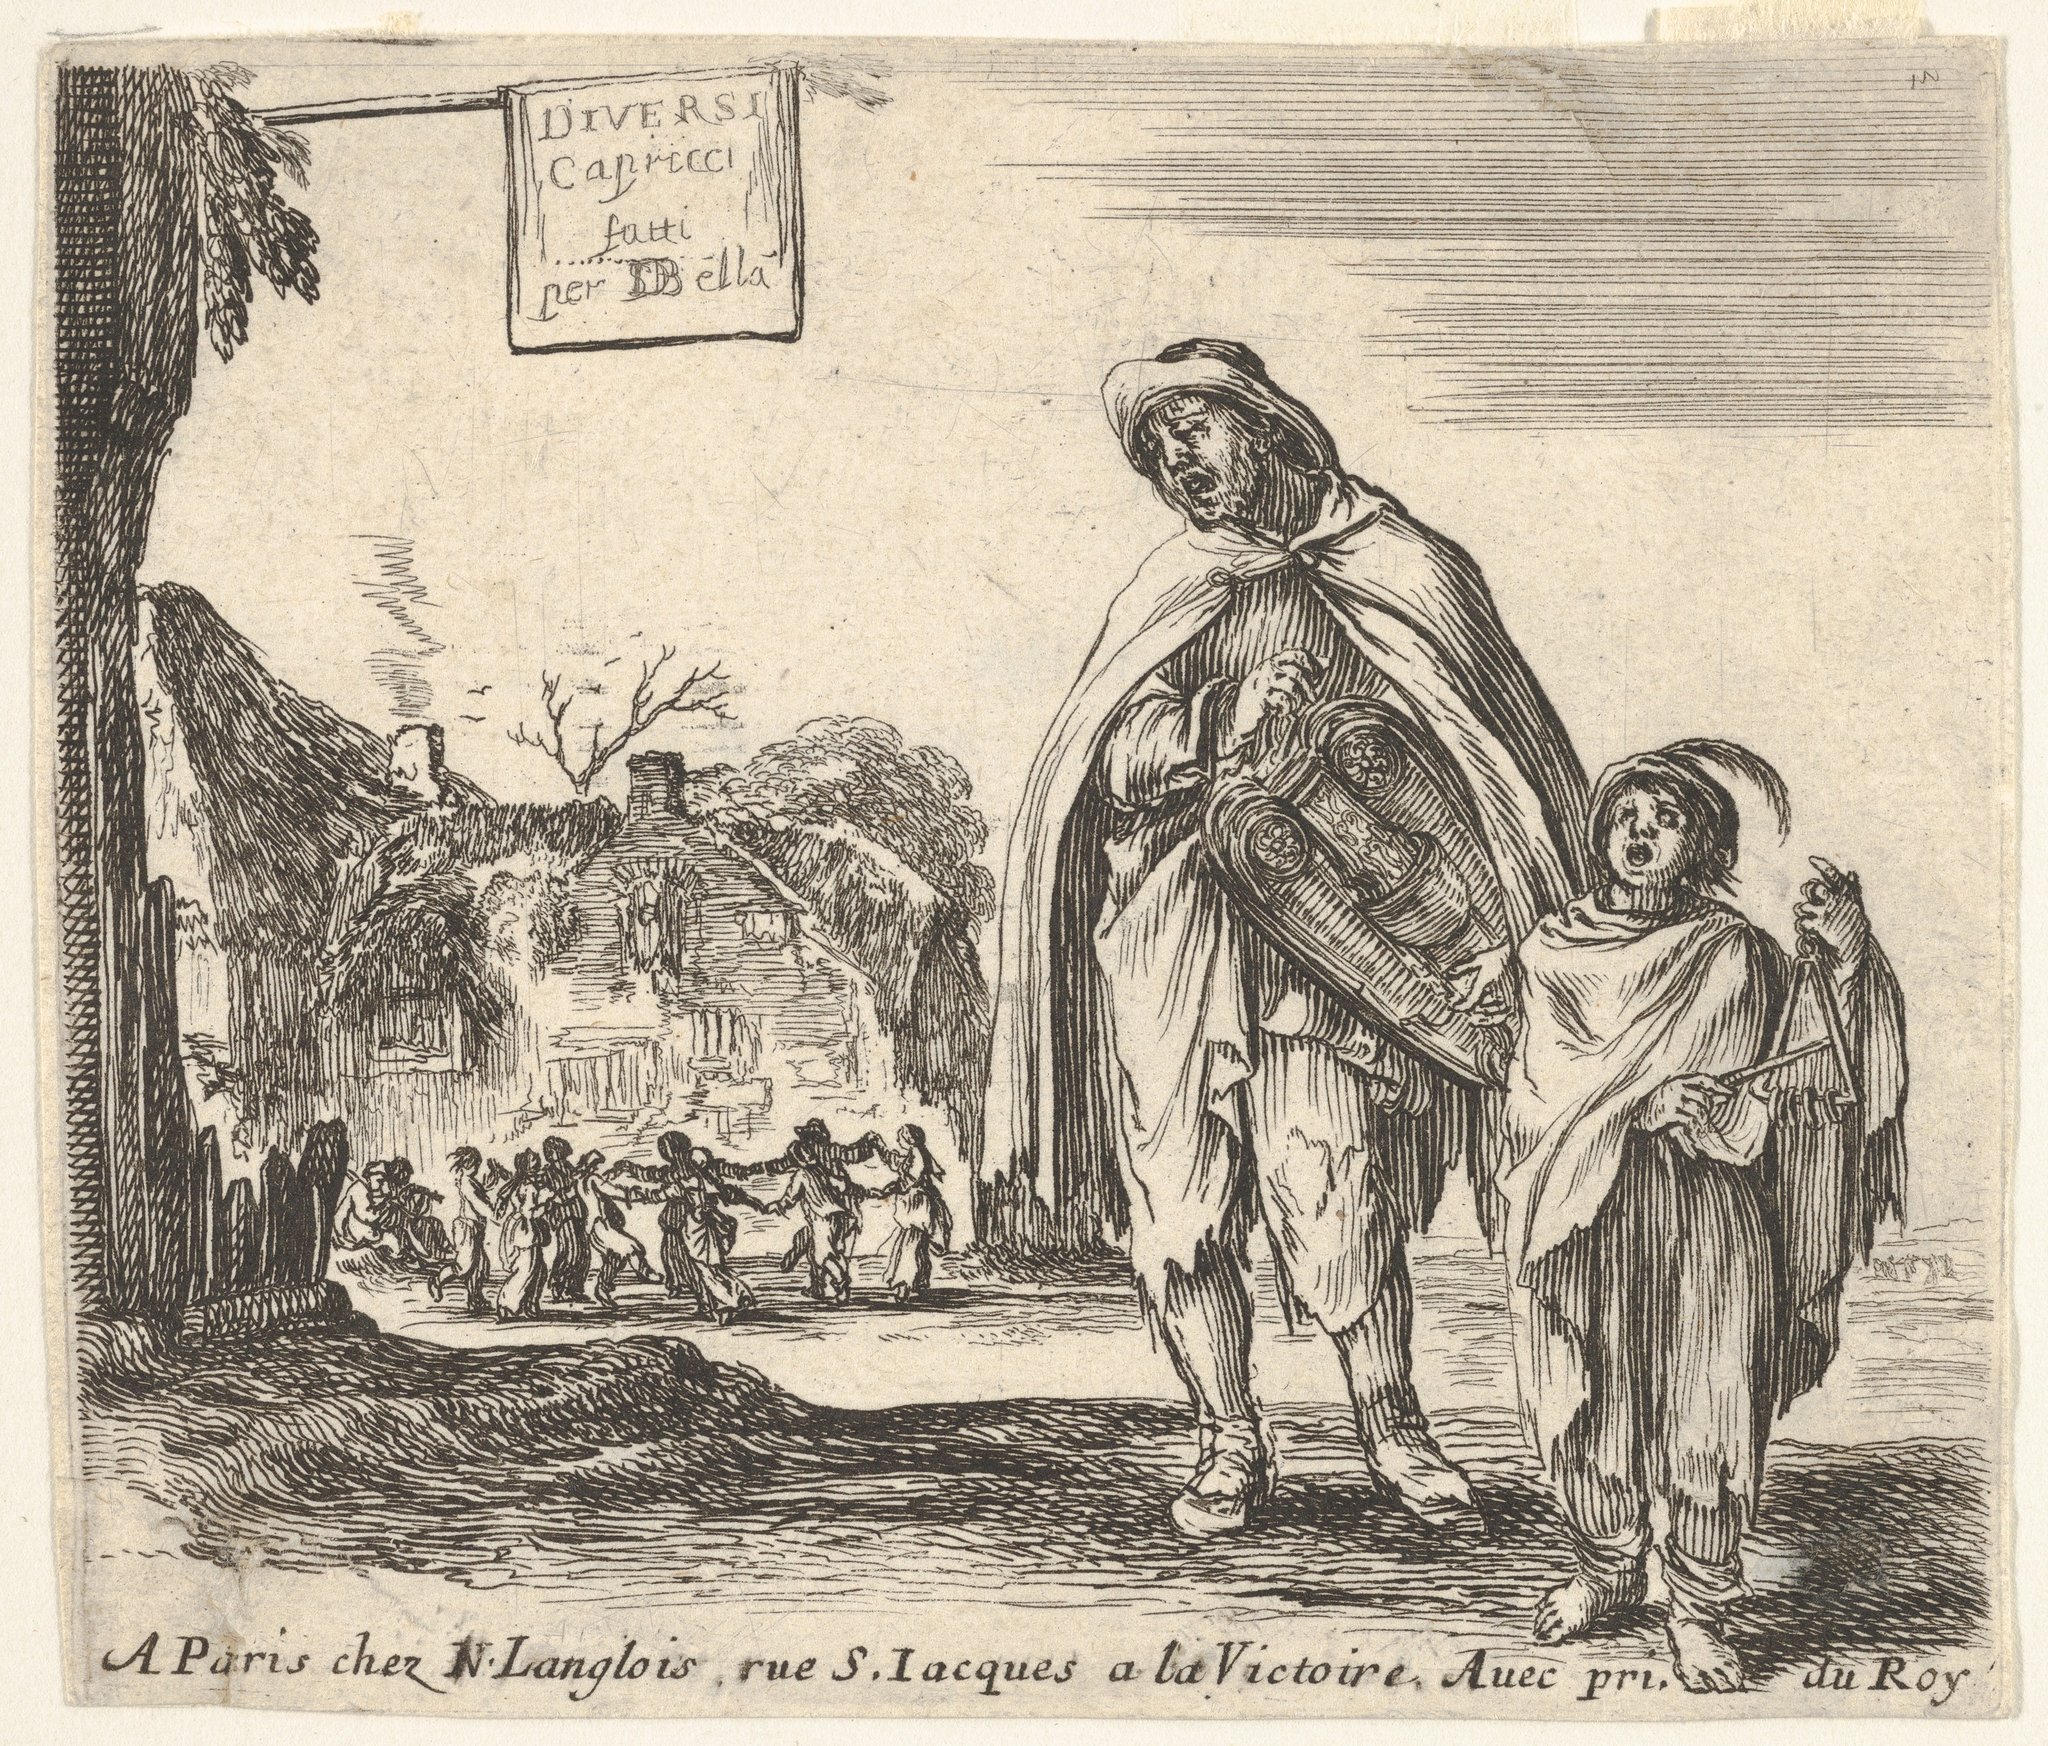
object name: print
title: Plate 1: a man sings and plays the hurdy gurdy, accompanied by a boy playing the triangle to right, a group of peasants dancing in a ring to left in background, title page for "Diversi Capricci"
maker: stefano della bella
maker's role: artist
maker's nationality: italian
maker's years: 1610-1664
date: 1644-1647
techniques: etching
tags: musical instruments,boys,men,singing,dancing